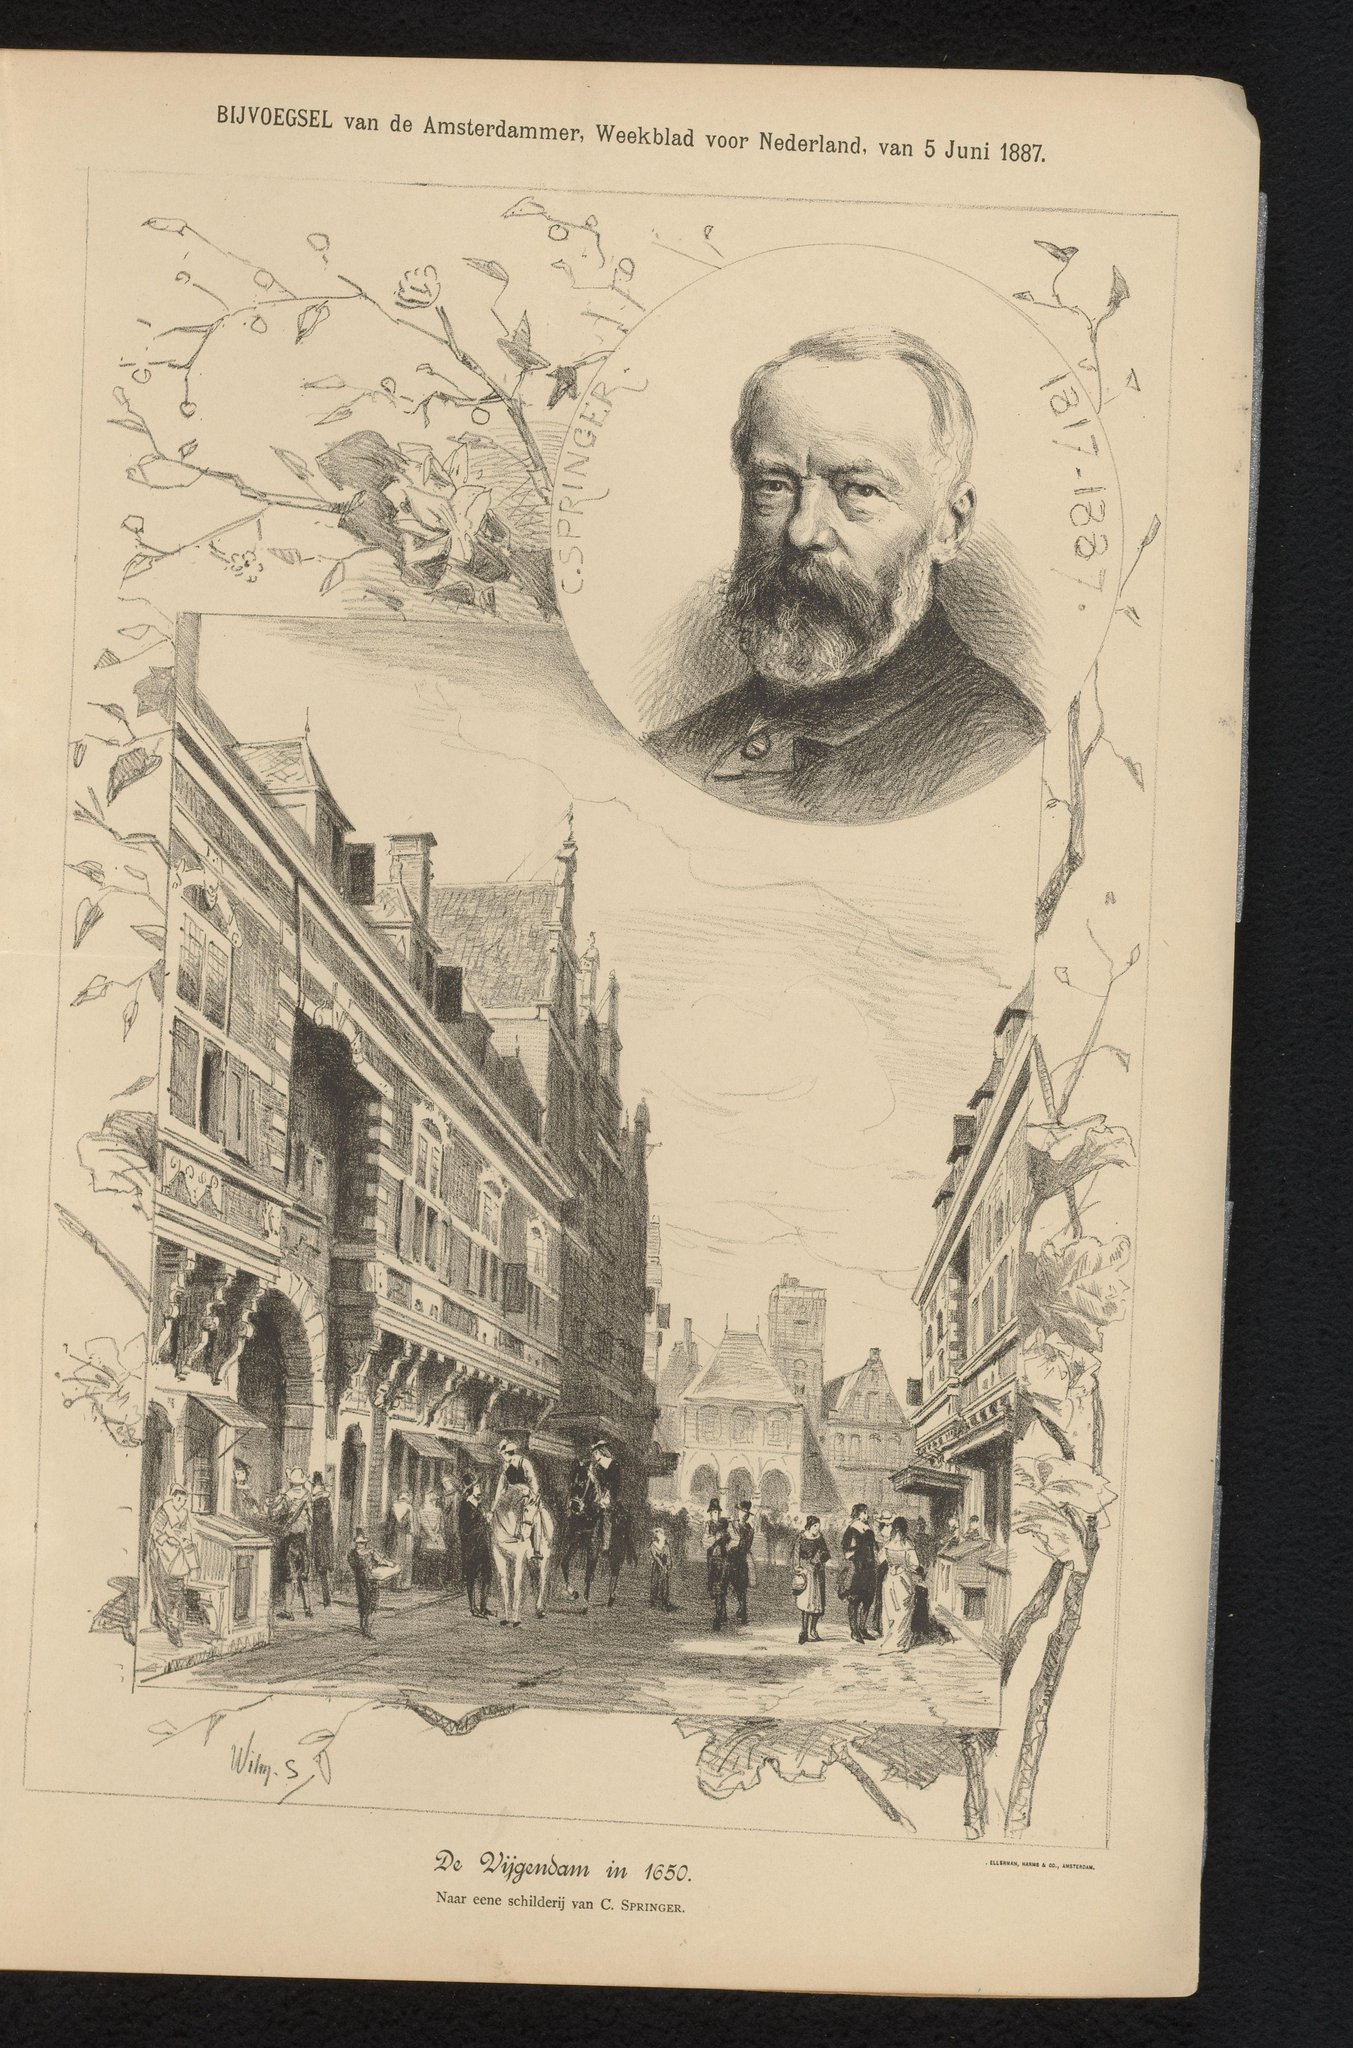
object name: print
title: De Vijgendam in 1650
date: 1887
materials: paper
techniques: lithograph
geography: netherlands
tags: amsterdam, painter, print maker, draughtsman, cornelis springer, historical persons, portrait, self-portrait of painter, portrait, self-portrait of artist, picture, painting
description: Gezicht op de Vijgendam te Amsterdam, naar het schilderij van Cornelis Springer. Bovenaan een portret van de schilder.